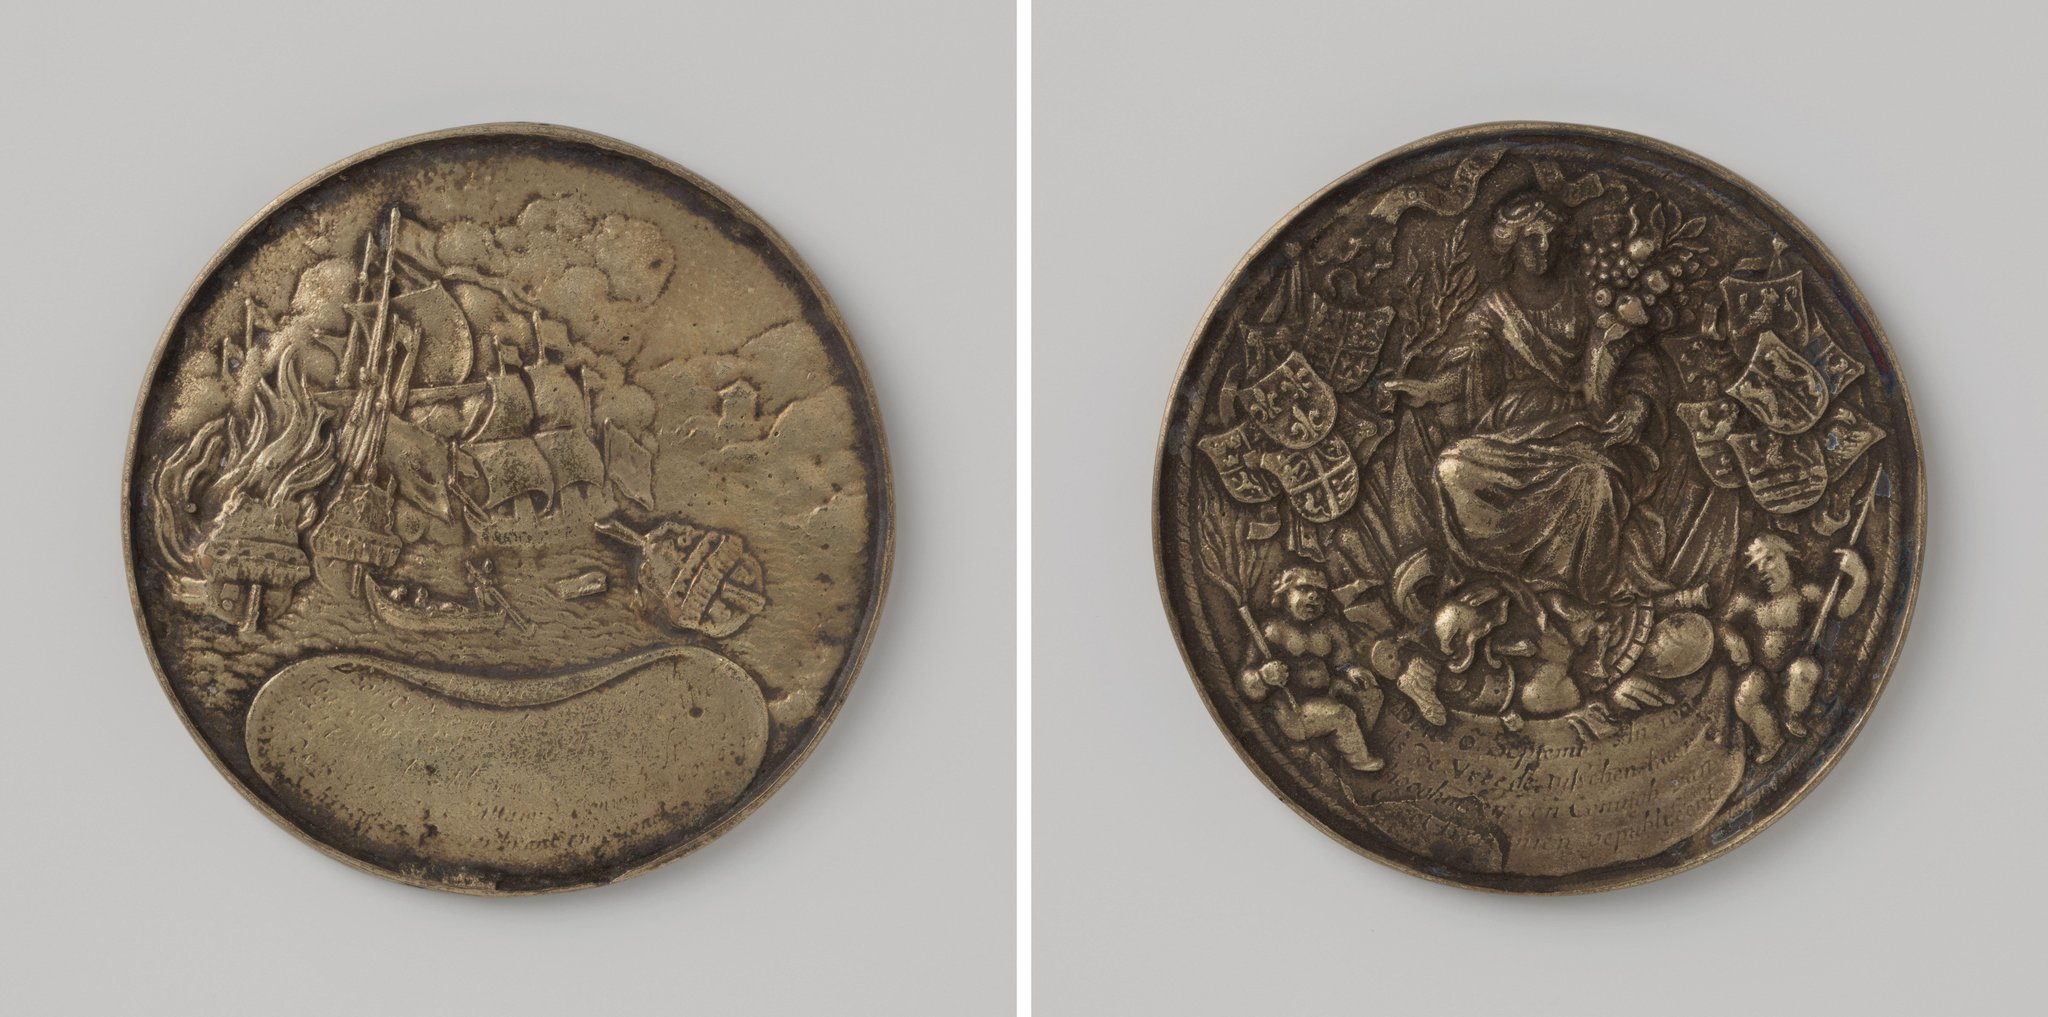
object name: history medal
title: Tocht naar Chatham door Michiel Adriaanszoon de Ruyter en de Vrede van Breda1667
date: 1667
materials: silver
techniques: casting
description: Messingkleurige gegoten penning, op de voorzijde het verbranden van Engelse schepen waaronder een niervormig tekstbord, op de keerzijde de Vrede, met olijftak en hoorn des overvloeds, zittend op een stapel wapentuig tussen draperien met de provinciale wapenschilden, onderaan een tekst tussen twee kinderen met zweep en pijl.